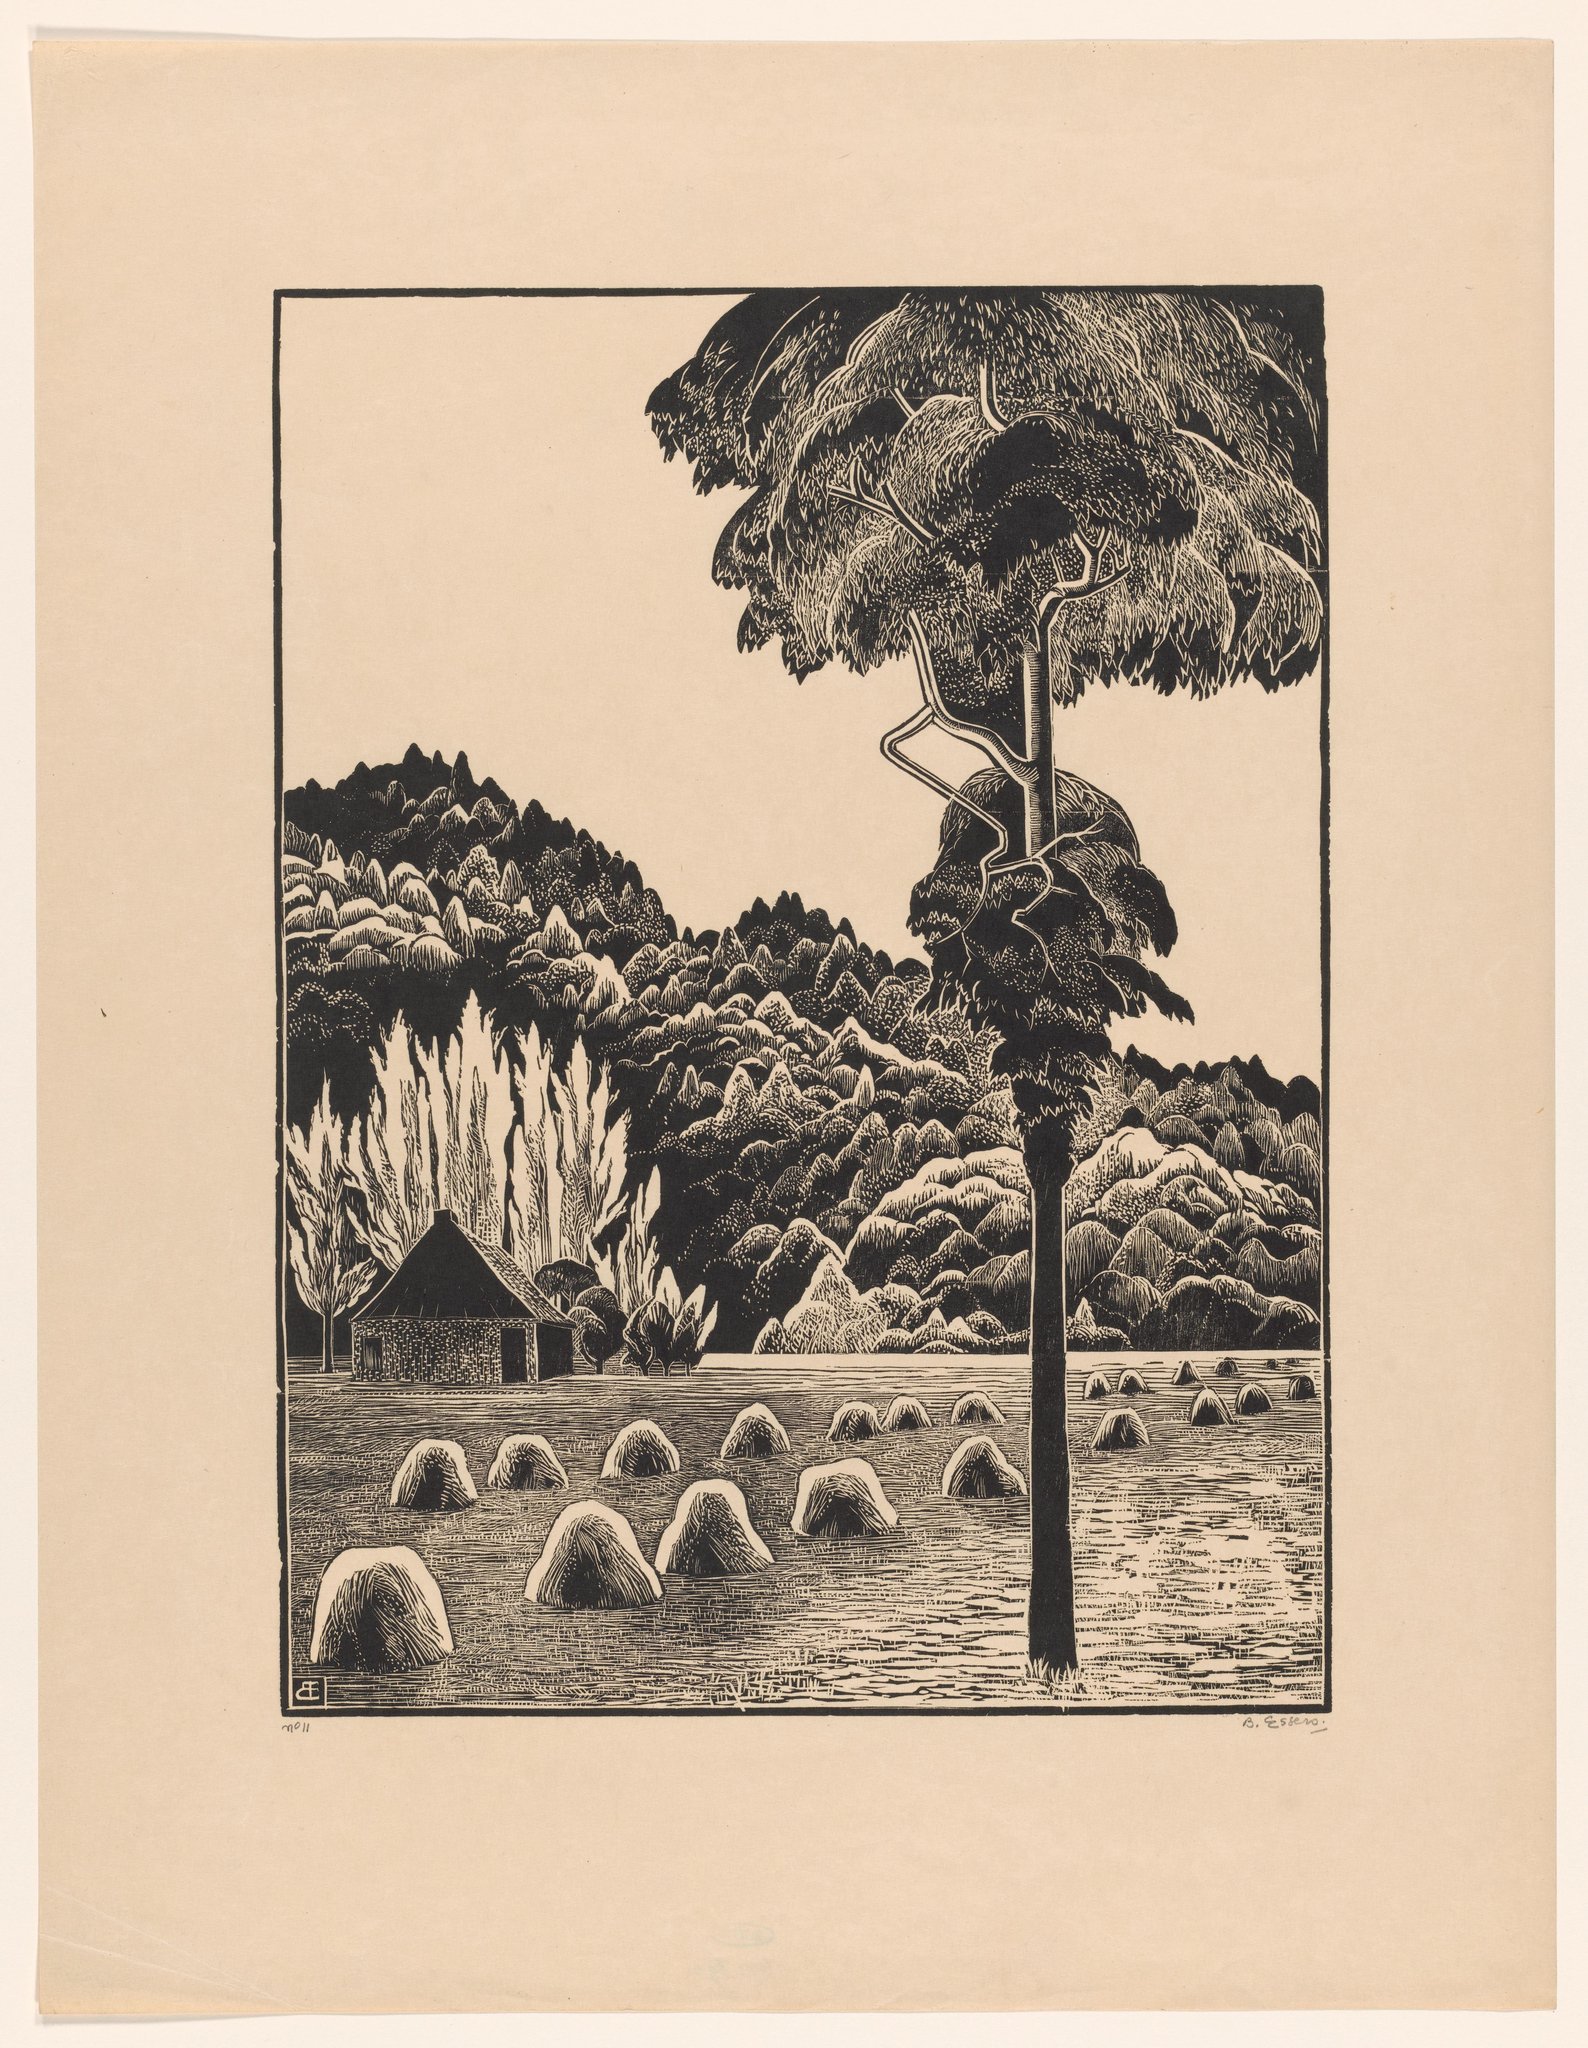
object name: print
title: Duinlandschap met hooioppers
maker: bernard essers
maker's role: print maker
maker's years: 1893-1945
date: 1931-1937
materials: paper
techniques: engraving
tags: trees, dunes (sea not visible); in the dunes, hay-cock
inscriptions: collector's mark: Lugt 2228, inscription: ‘No. 11’